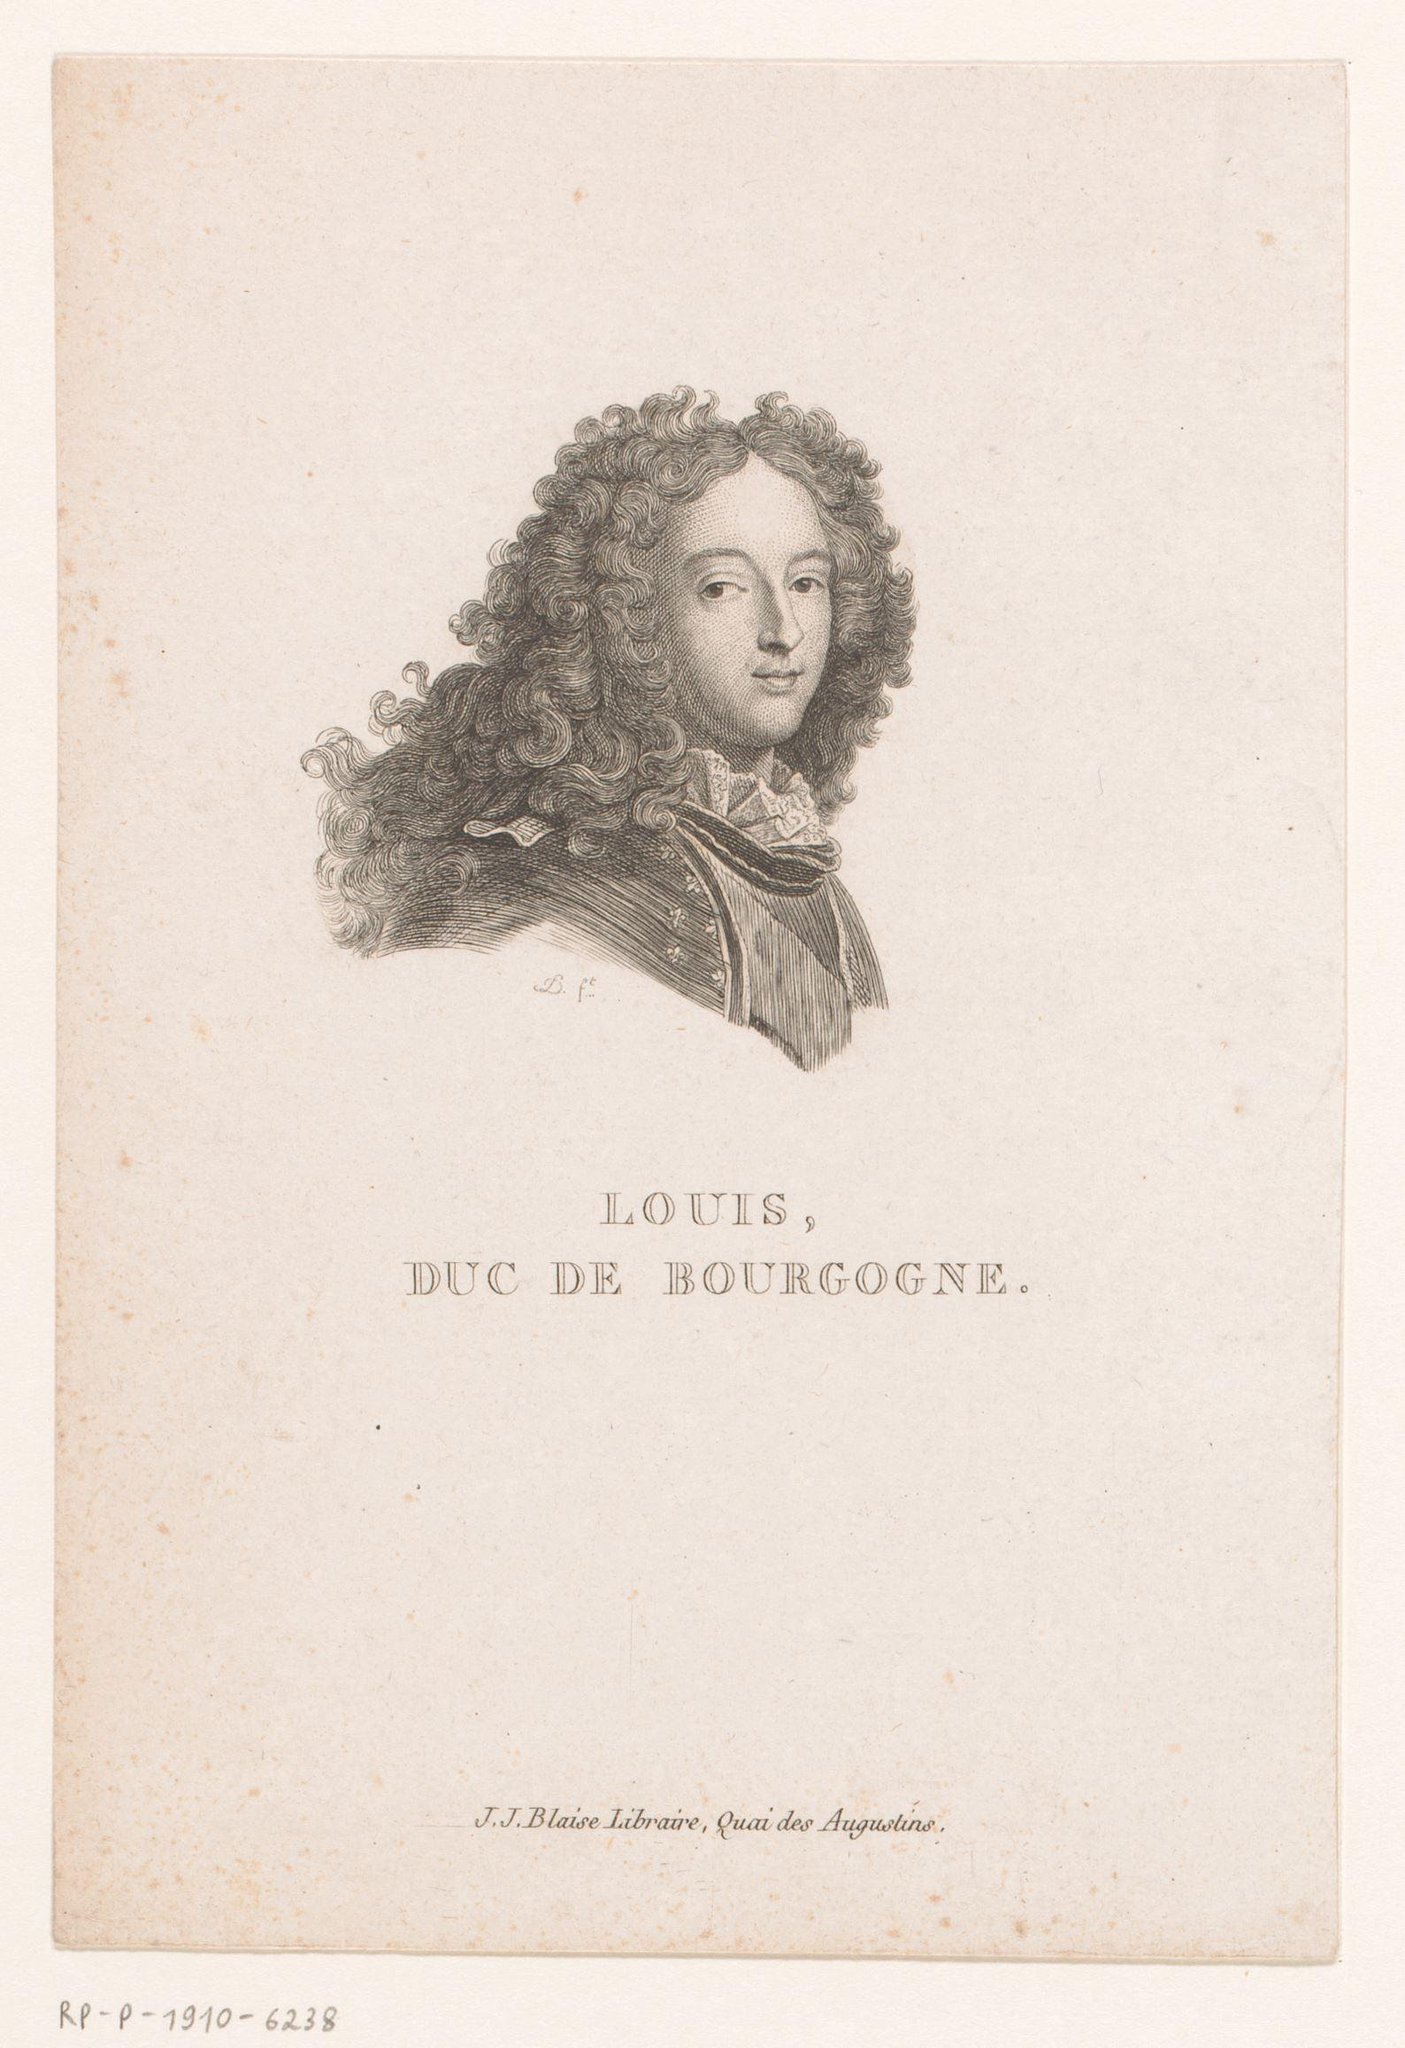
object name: print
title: Louis, duc de Bourgogne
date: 1750-1800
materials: paper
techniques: engraving, etching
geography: paris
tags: lodewijk van frankrijk (hertog van bourgondië), historical persons, nobility and patriciate; chivalry, knighthood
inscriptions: collector's mark: Lugt 2228